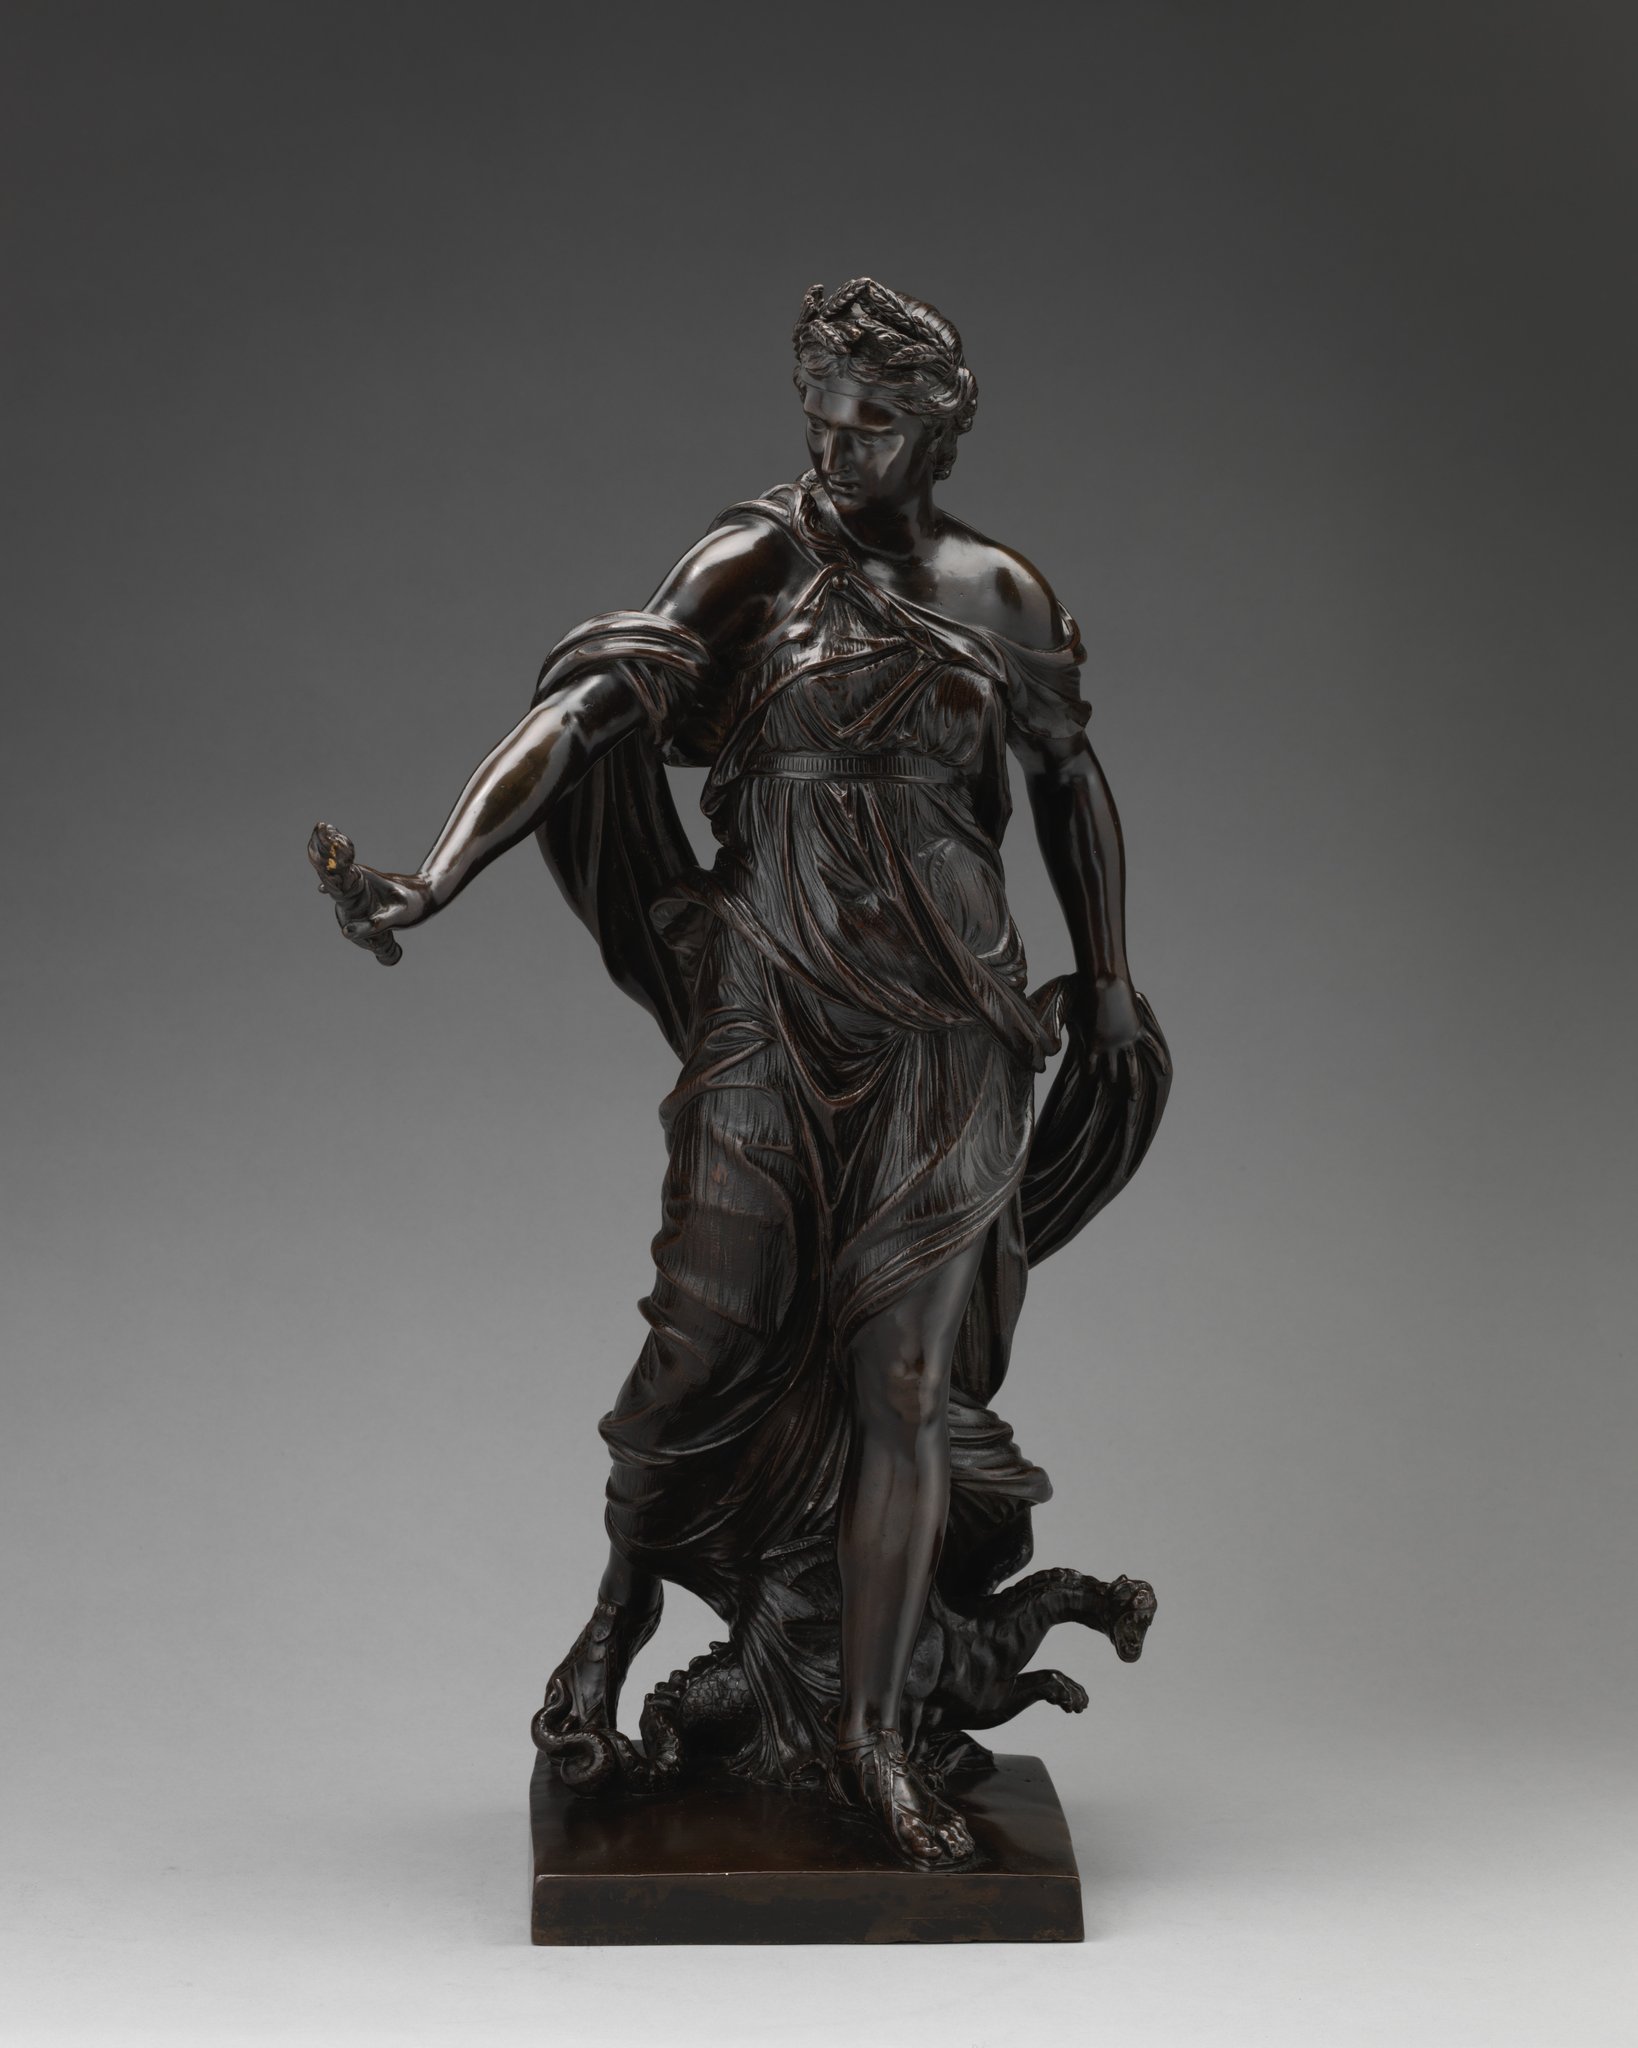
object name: statuette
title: Ceres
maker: michel anguier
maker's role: artist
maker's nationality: french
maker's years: 1612-1686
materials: bronze